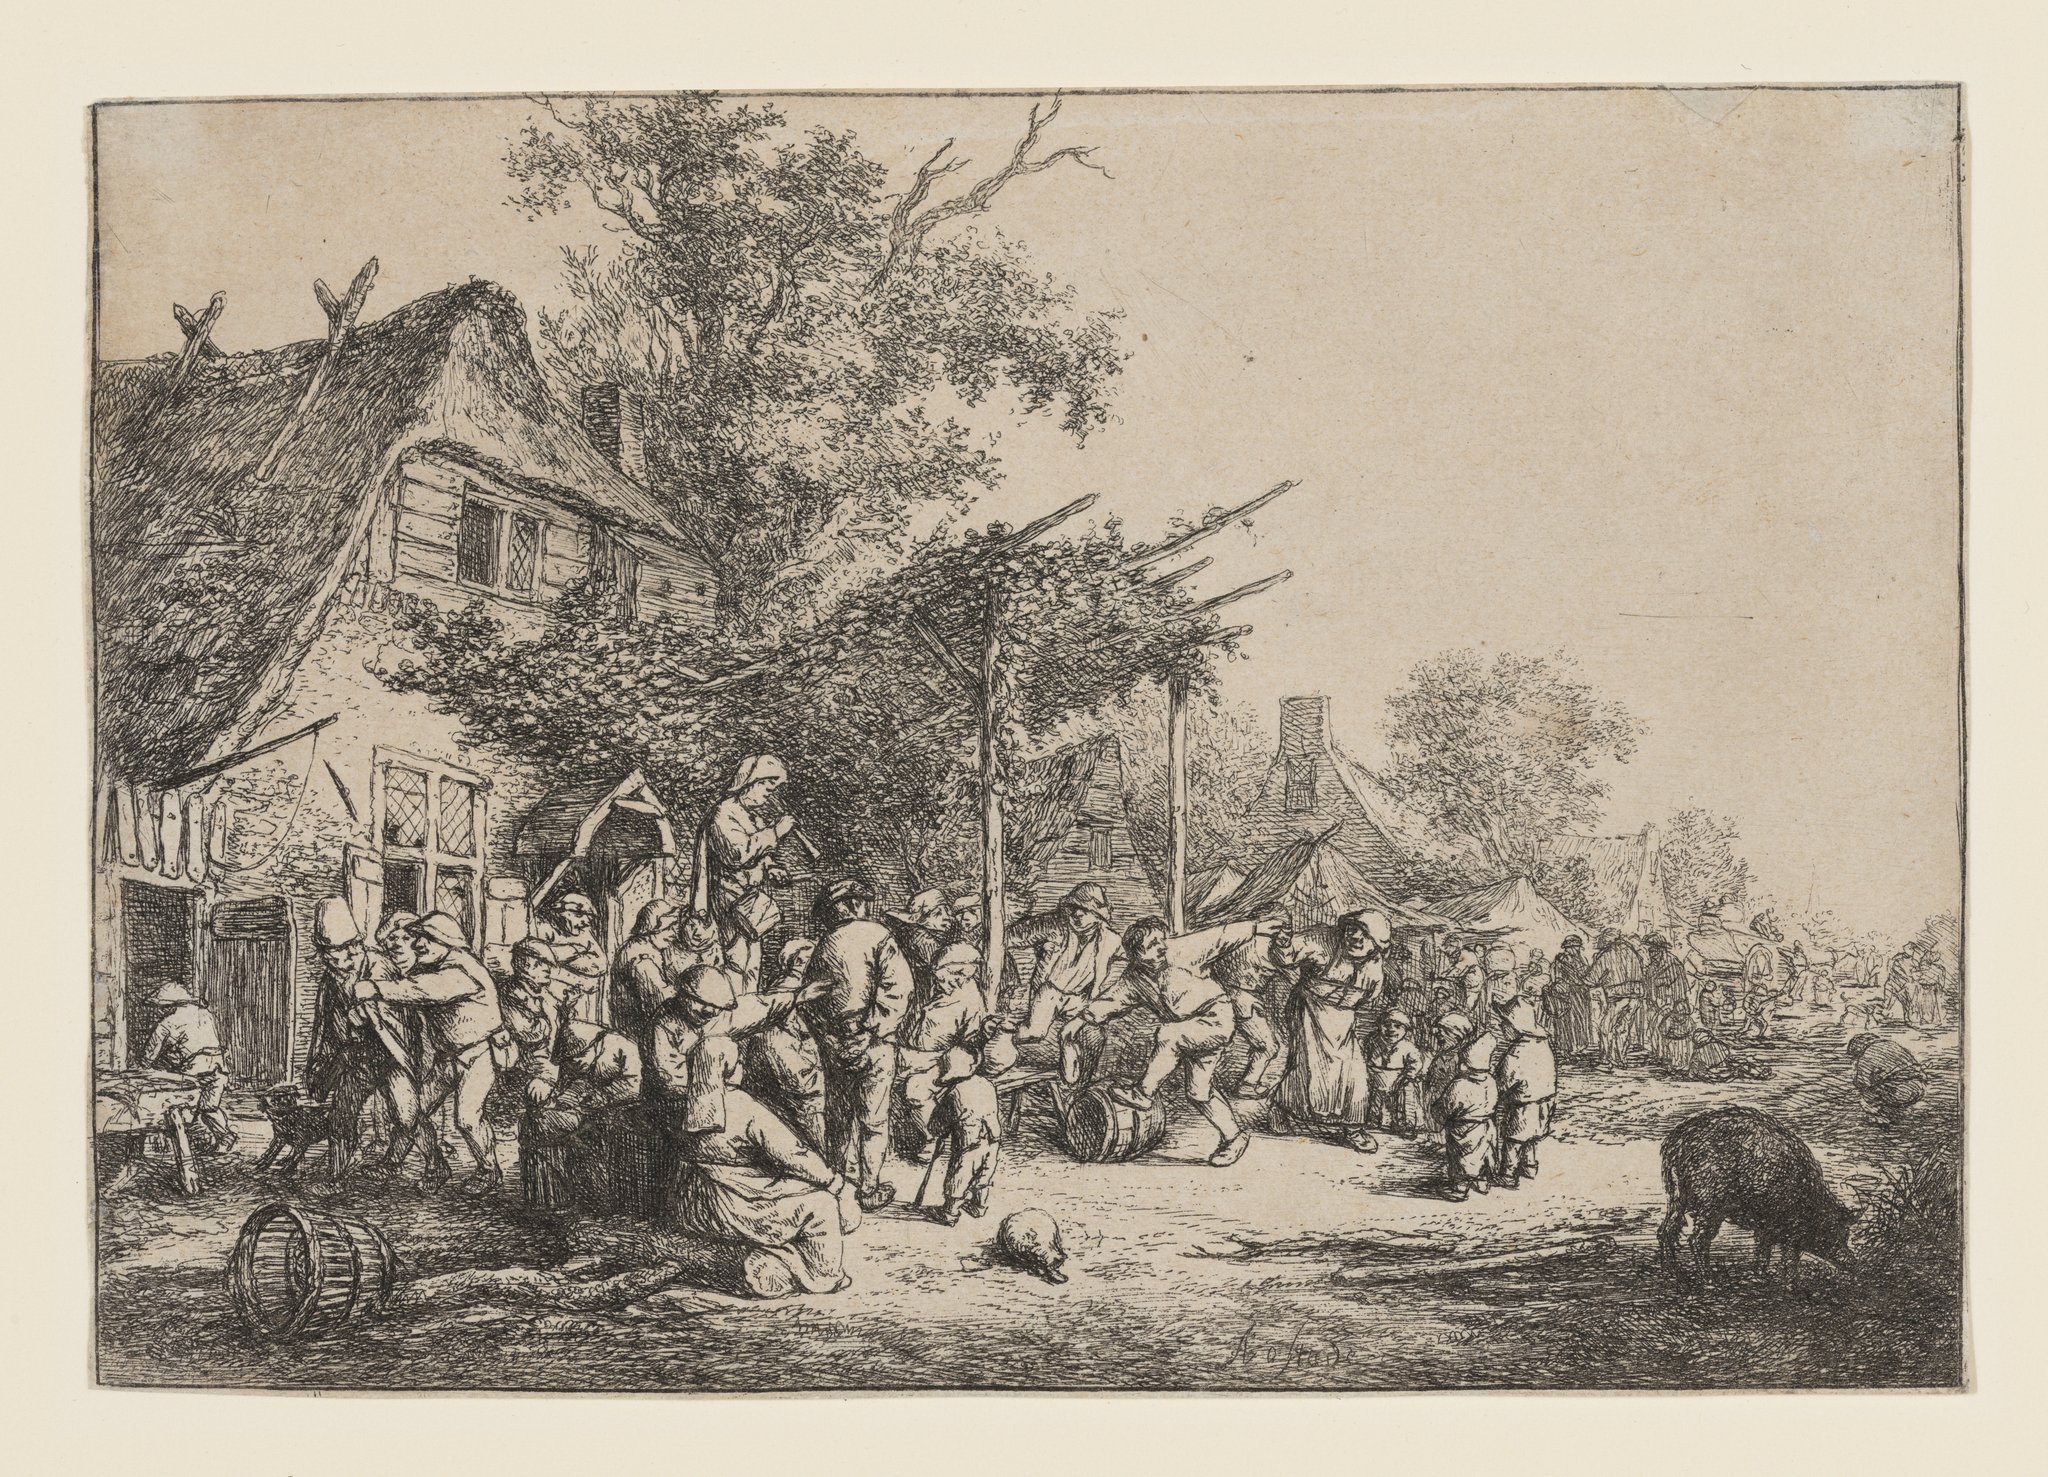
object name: print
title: Dance Under the Trellis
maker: adriaen van ostade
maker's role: artist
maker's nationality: dutch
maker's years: 1610-1685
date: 1652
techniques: etching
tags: dancing